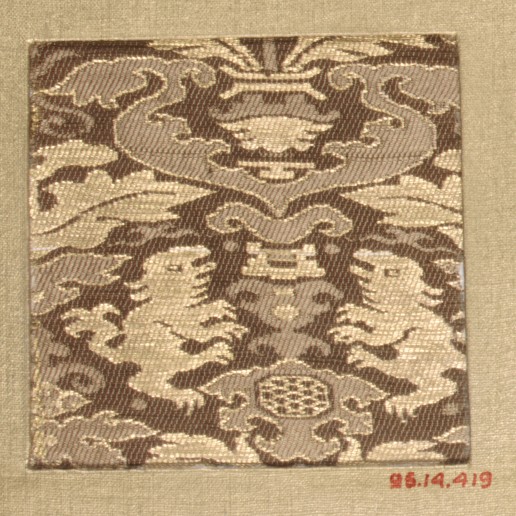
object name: piece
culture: japanese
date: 1701-1900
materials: silk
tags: animals